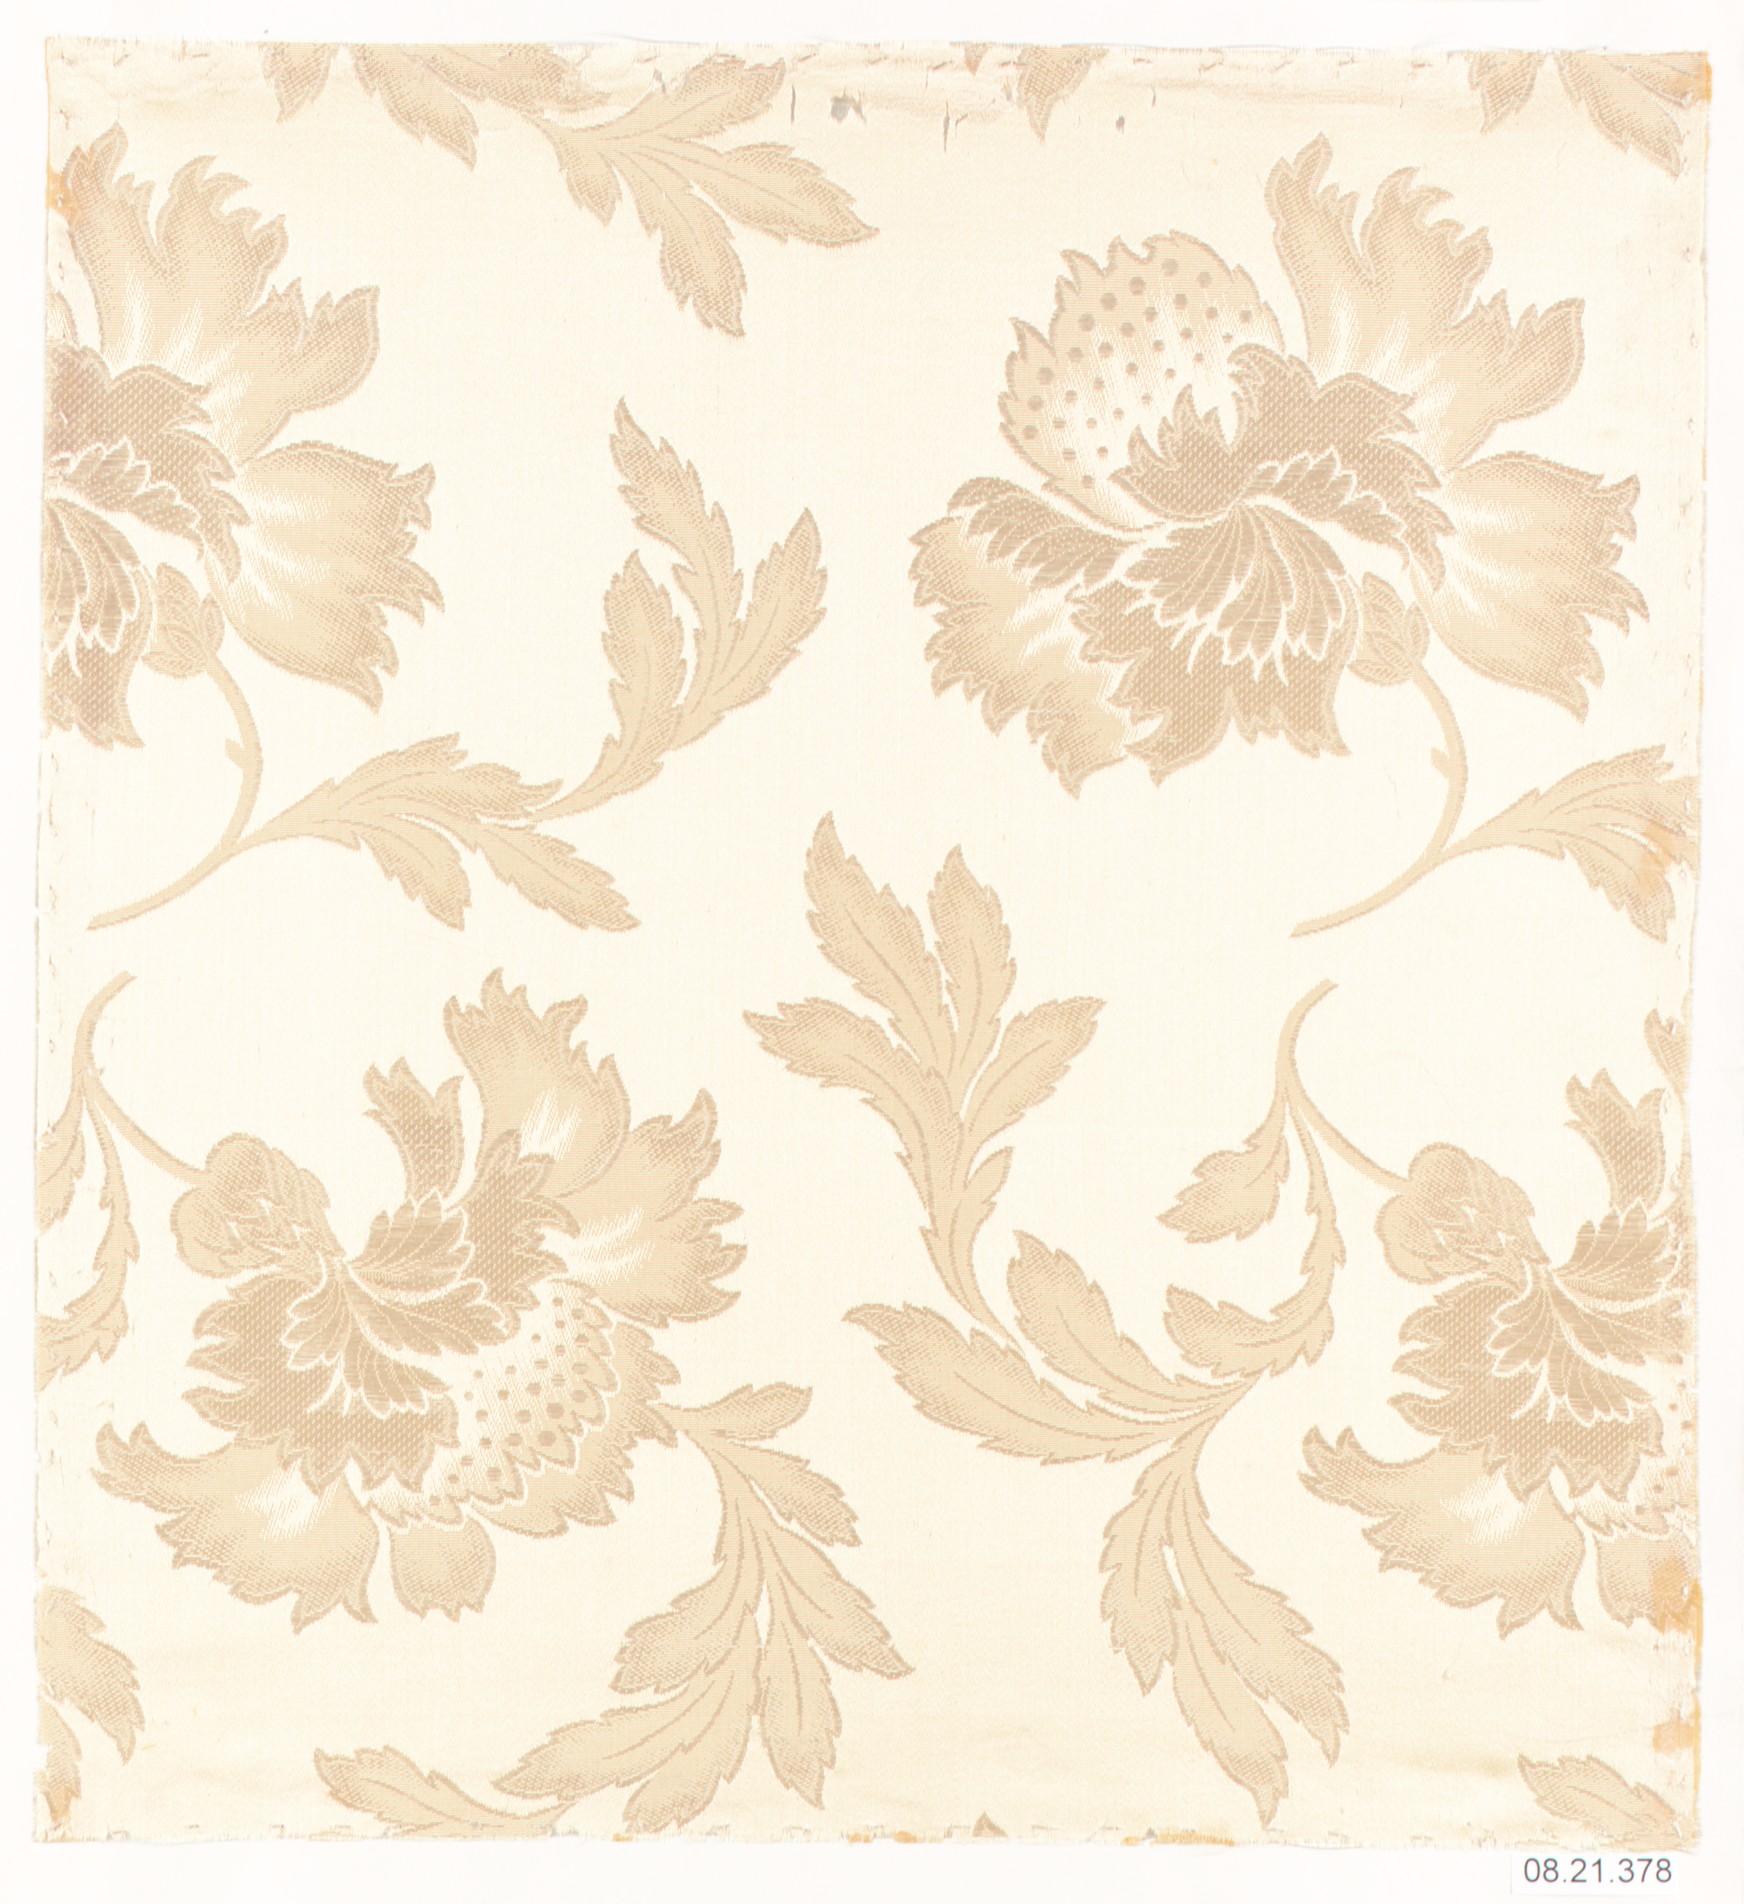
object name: textile sample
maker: Anonymous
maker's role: designer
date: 1900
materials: silk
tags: flowers,leaves